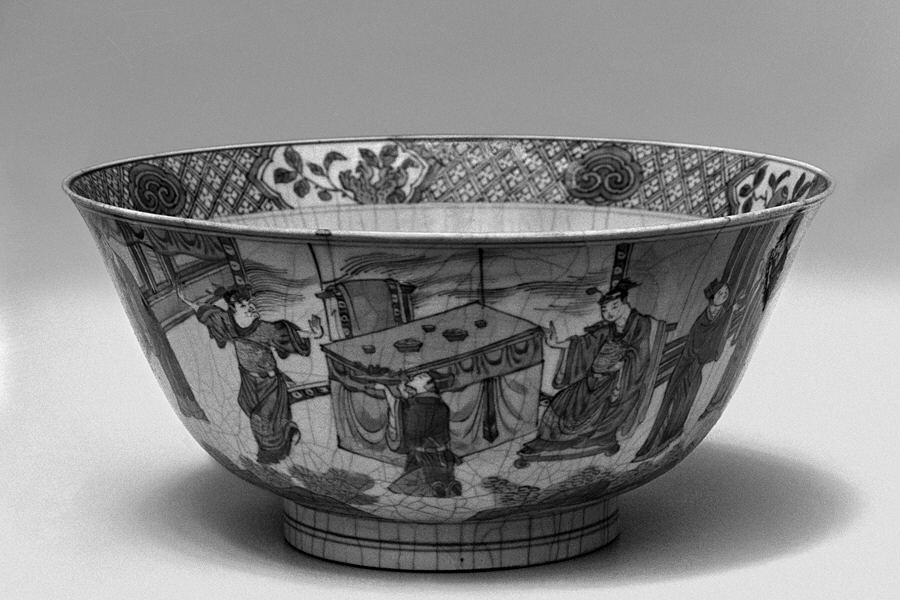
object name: bowl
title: Bowl with narrative scene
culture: chinese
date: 1667-1733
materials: cobalt, porcelain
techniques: underglaze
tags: men